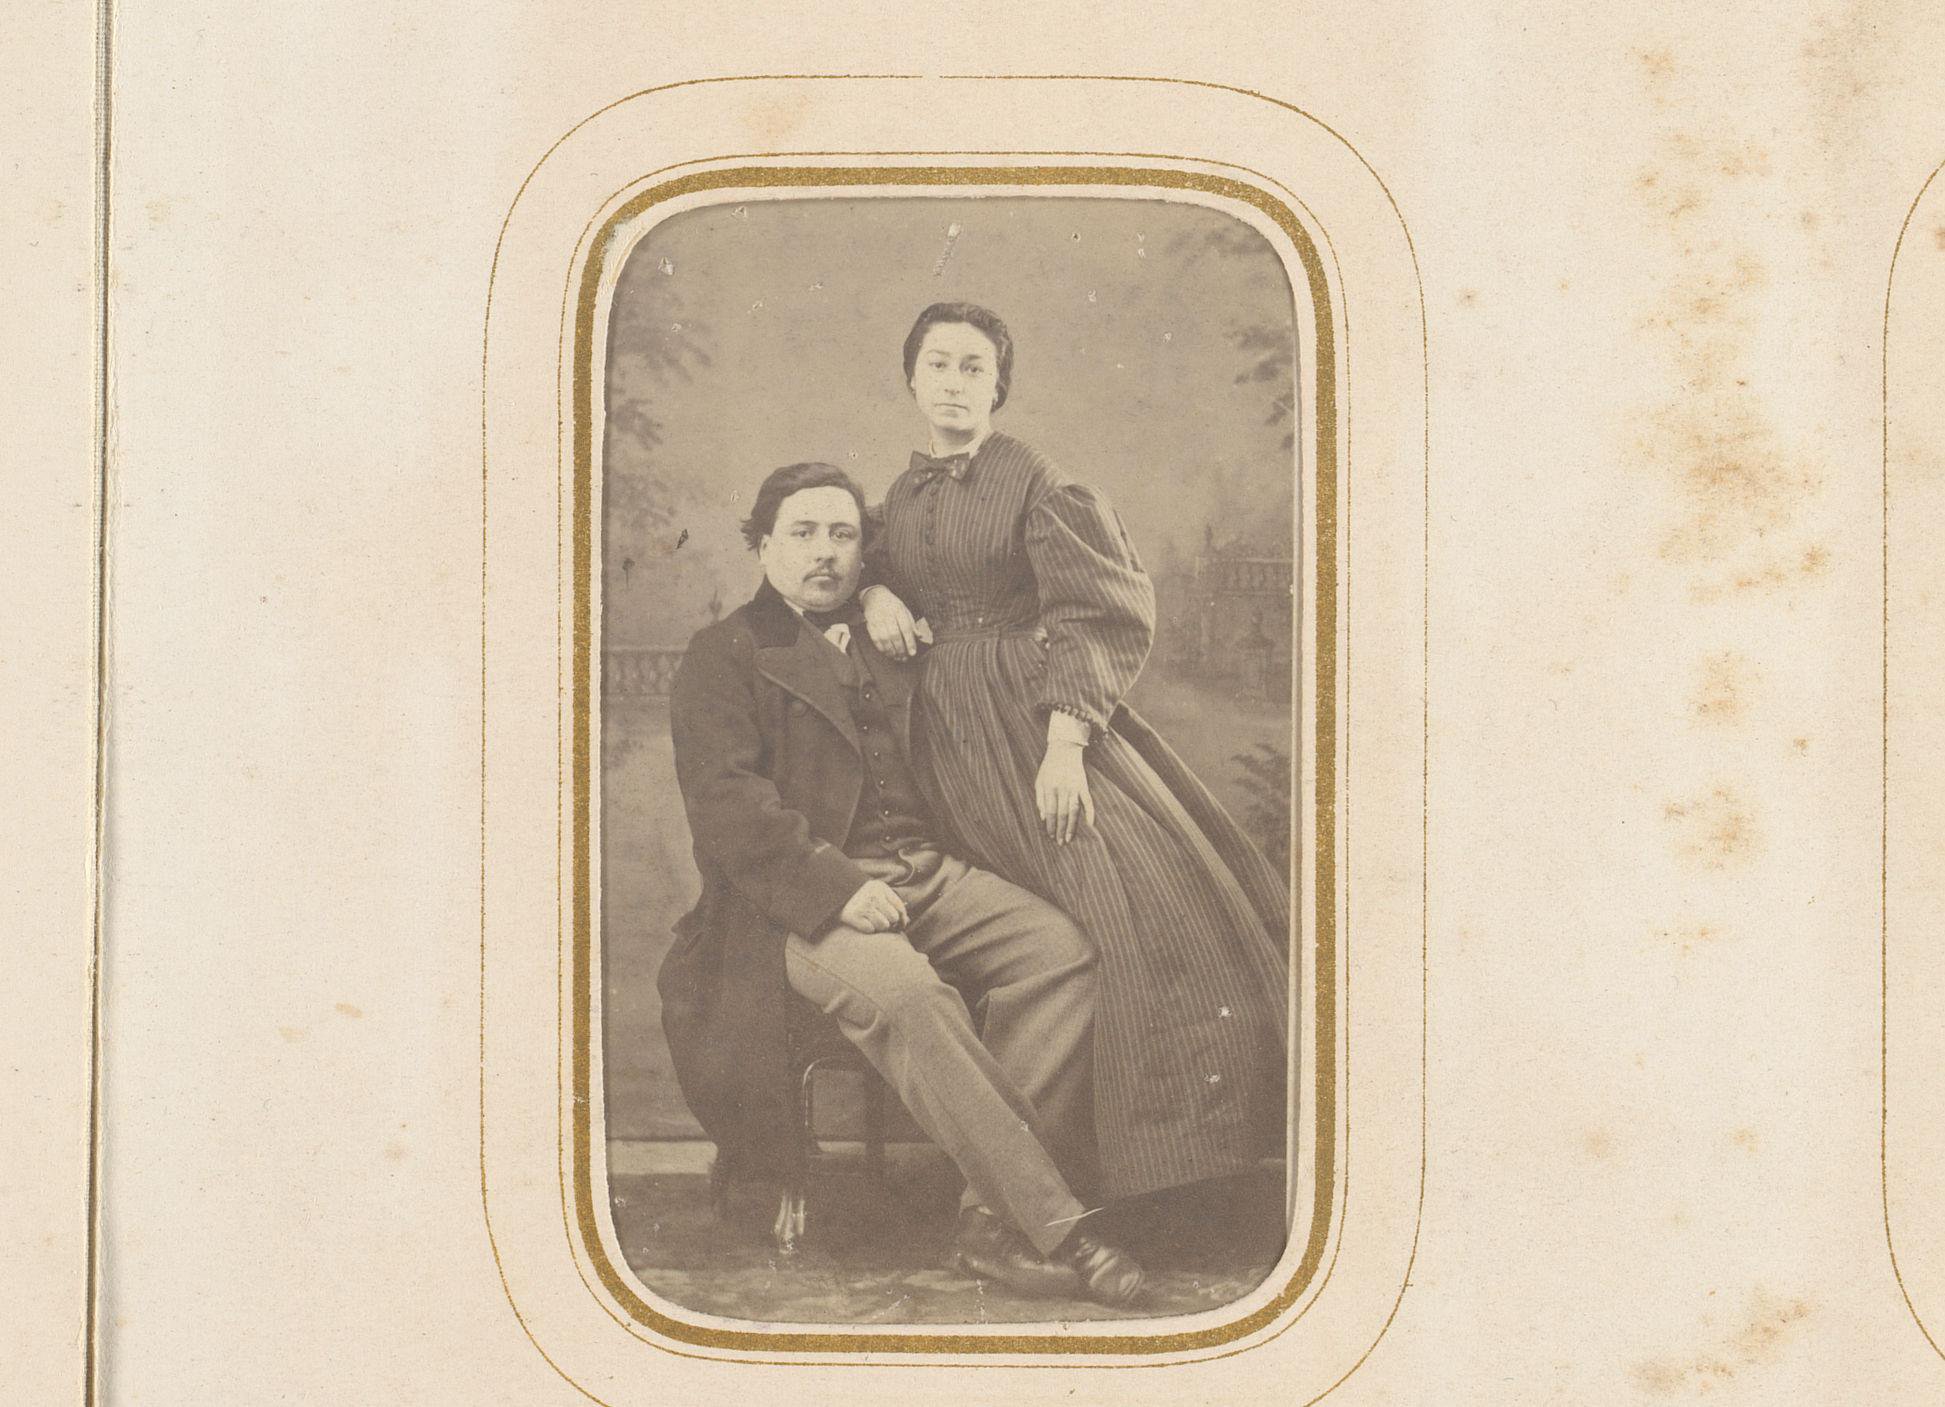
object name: album leaf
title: Portret van een echtpaar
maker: Anonymous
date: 1860-1890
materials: cardboard, photographic support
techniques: albumen print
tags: couple of lovers